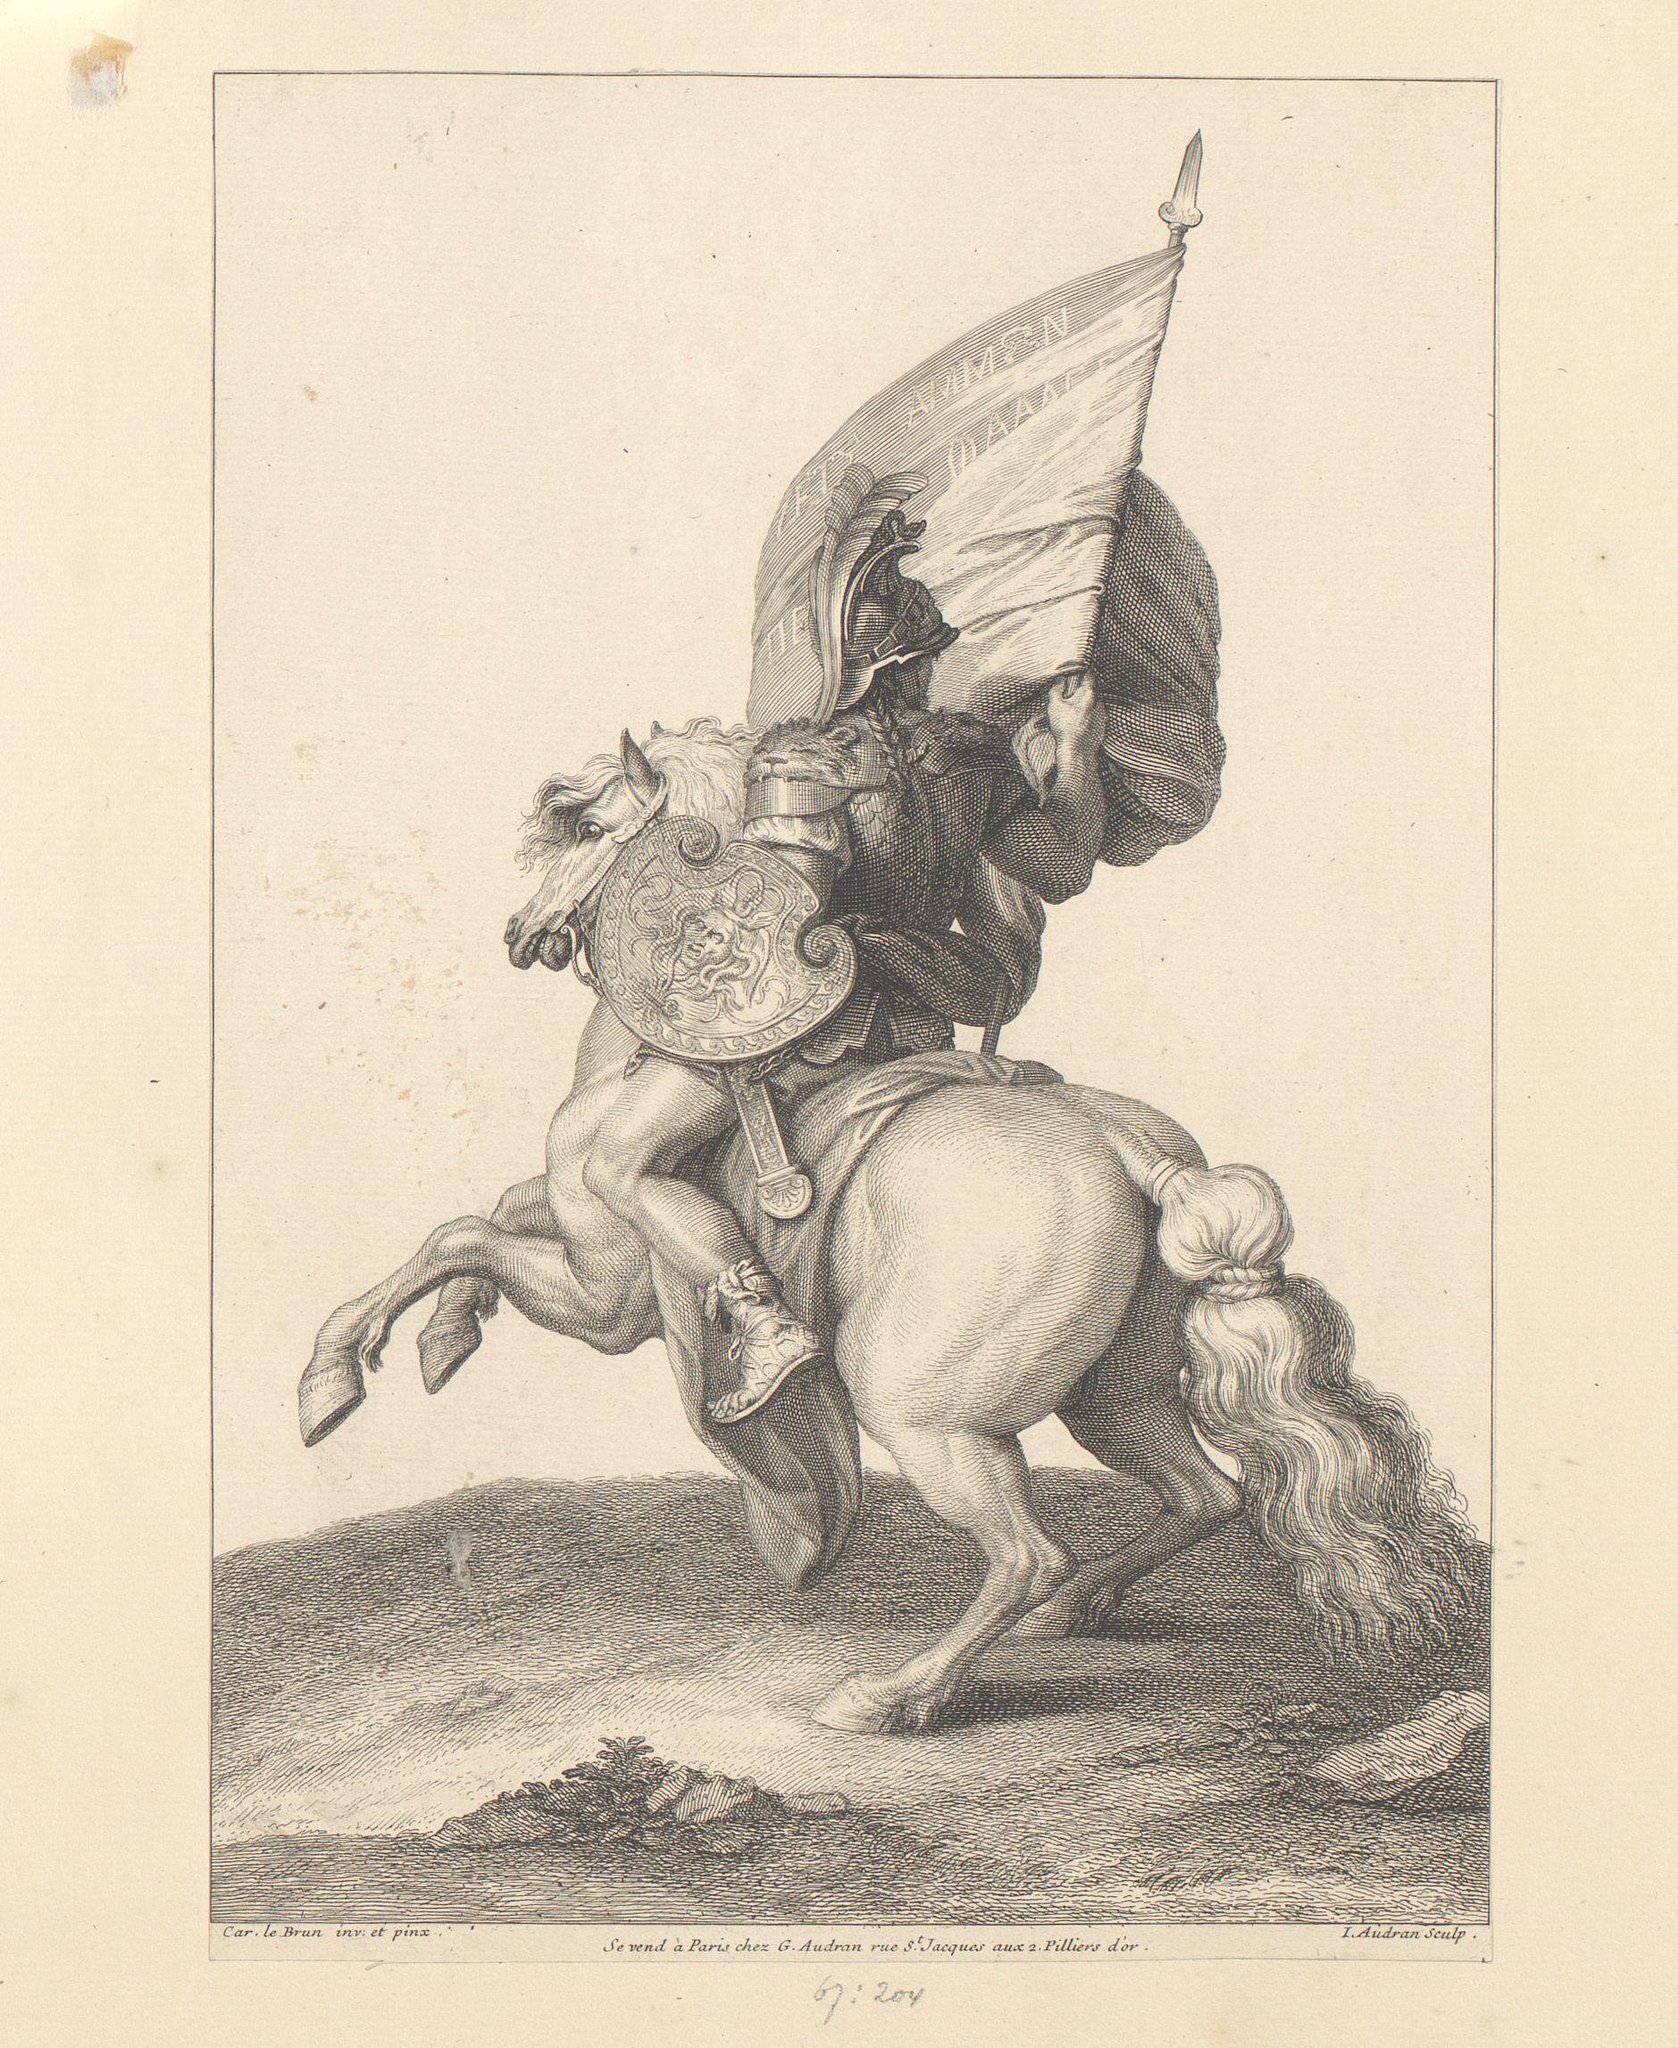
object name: print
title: L'ouvrage de Charles le Brun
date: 1677-1756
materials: paper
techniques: engraving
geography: paris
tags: riding a horse, ass, or mule; rider, horseman, standard-bearer, flag-bearer, (military) standard-bearer, gorgoneion, head of medusa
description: Deze prent maakt deel uit van een album.